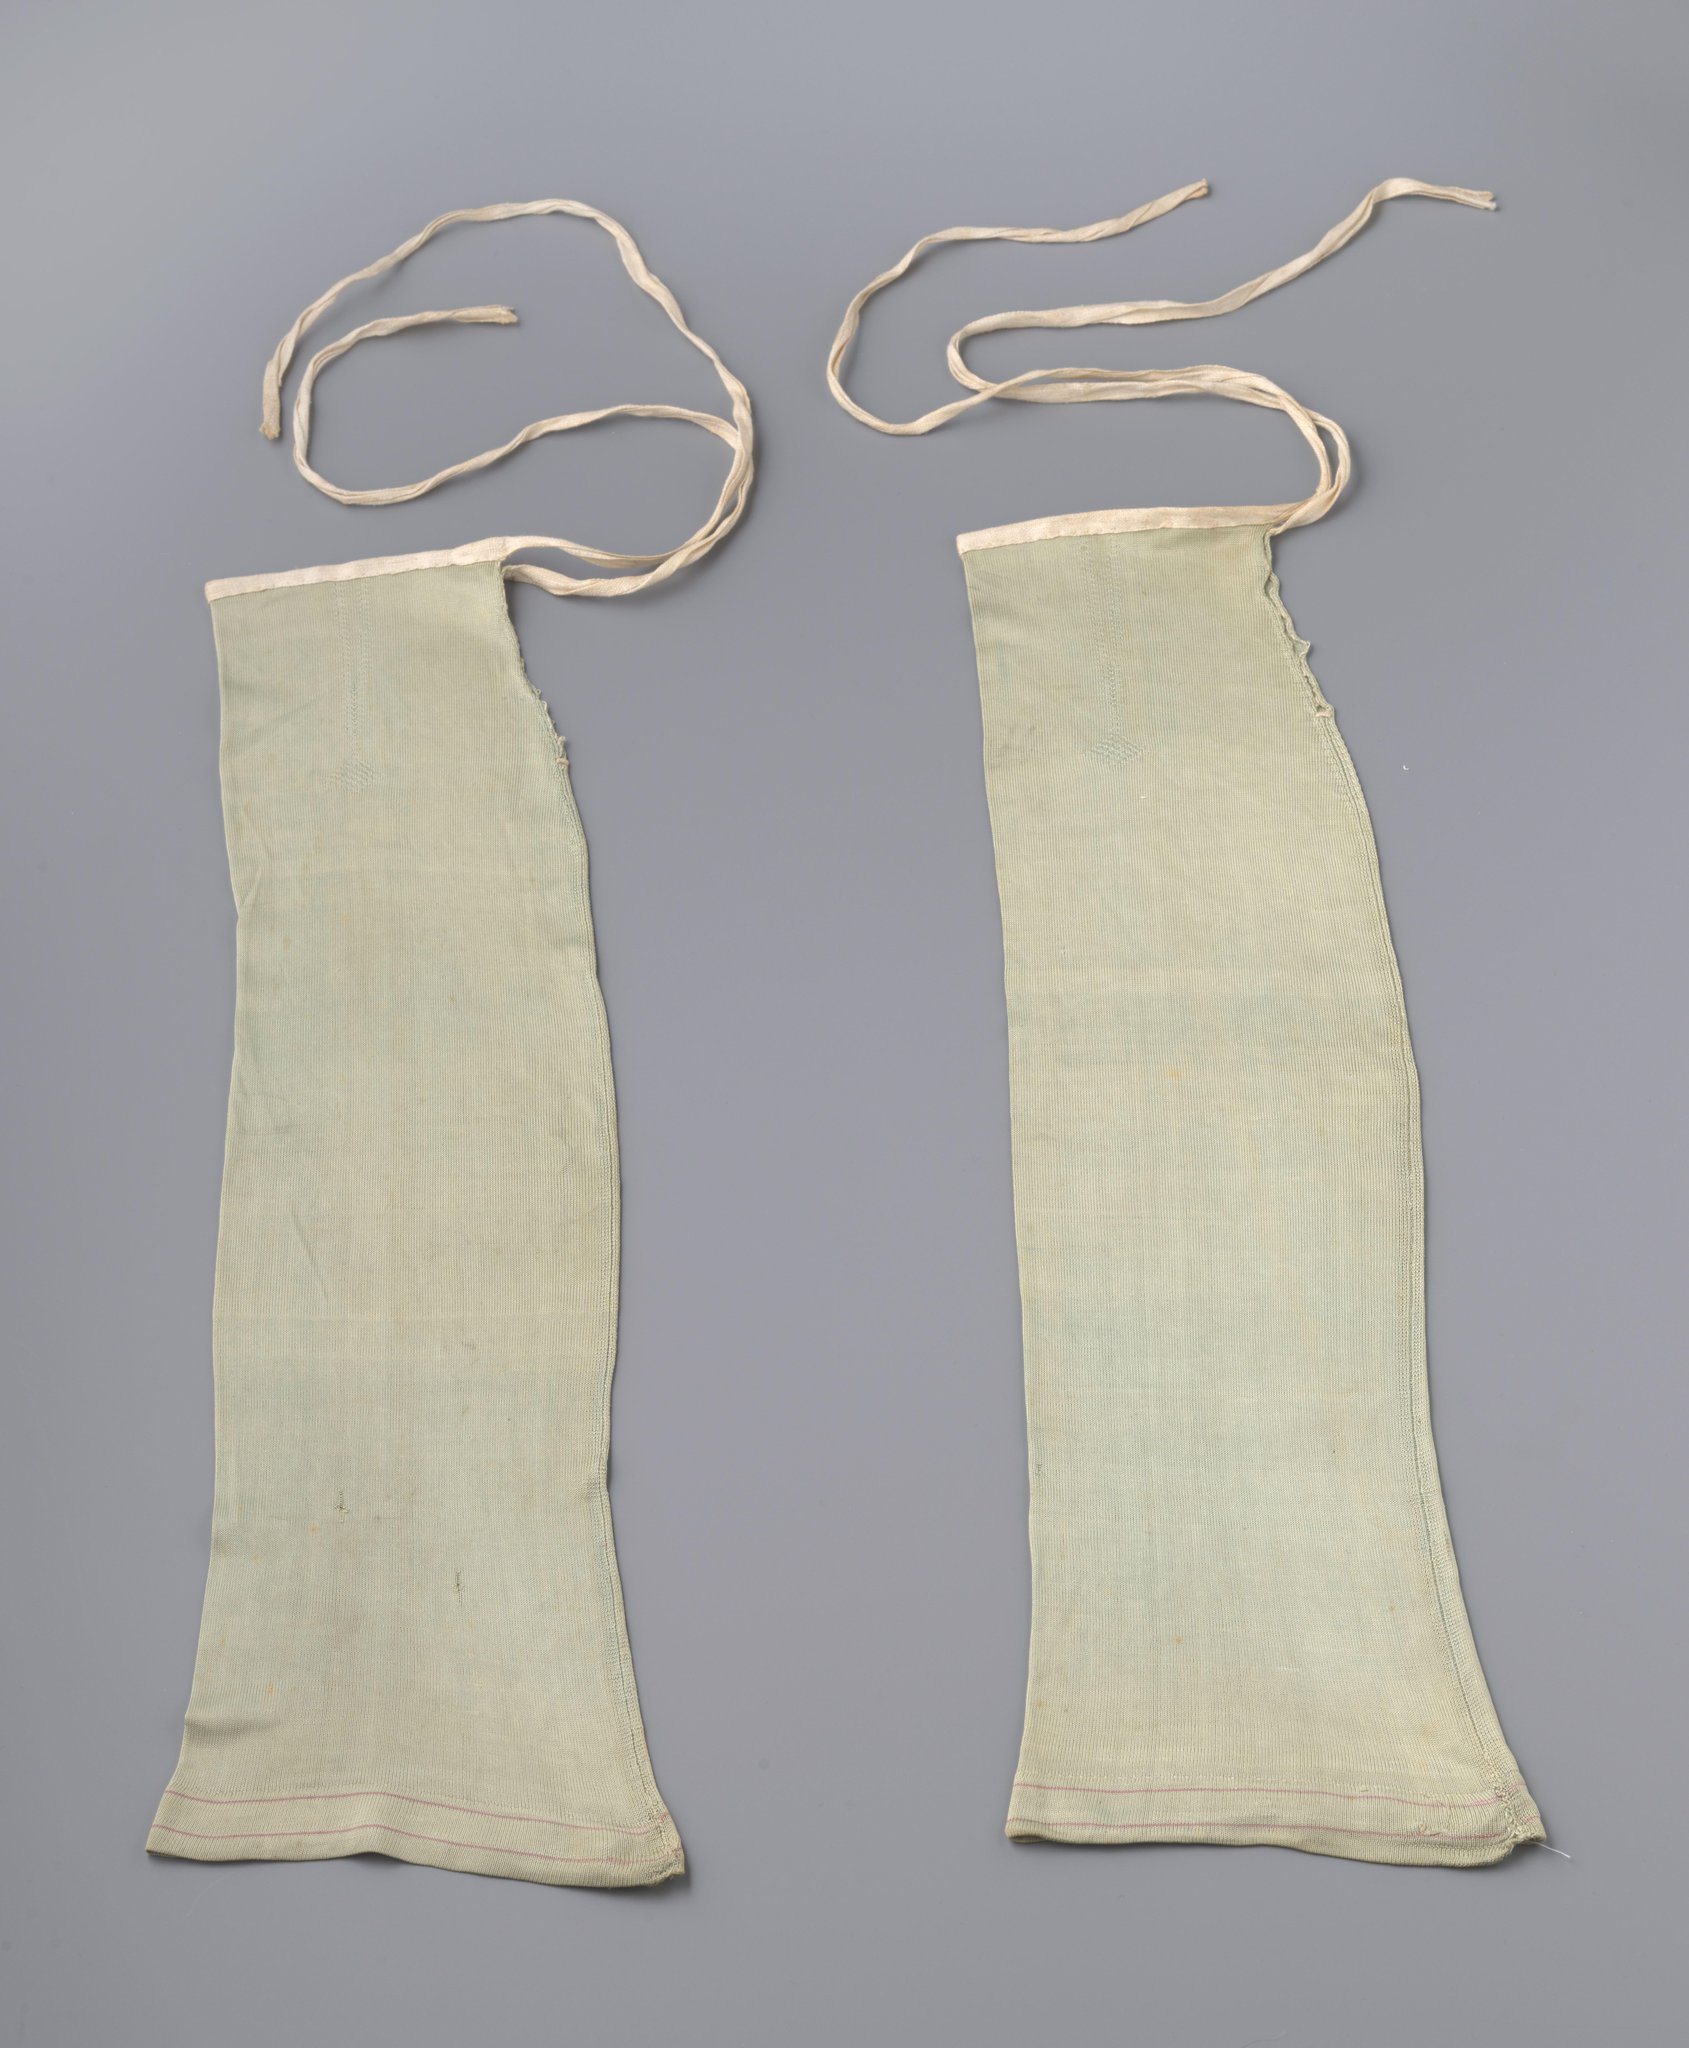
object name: clothing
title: Slob(?)kous van turquoise zijden tricot, zonder voet, bij de klink lange ecrukleurige linnen linten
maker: Anonymous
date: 1700-1800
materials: linen, silk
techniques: knitting, weave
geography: netherlands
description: Slob(?)kous van turquoise zijden tricot met een diamantvomige decoratie op de klink. Zonder voet, split bij de hiel. Bij de klink lange ecrukleurige linnen linten. Langs de bovenrand twee fijne meegebreide paarse strepen.